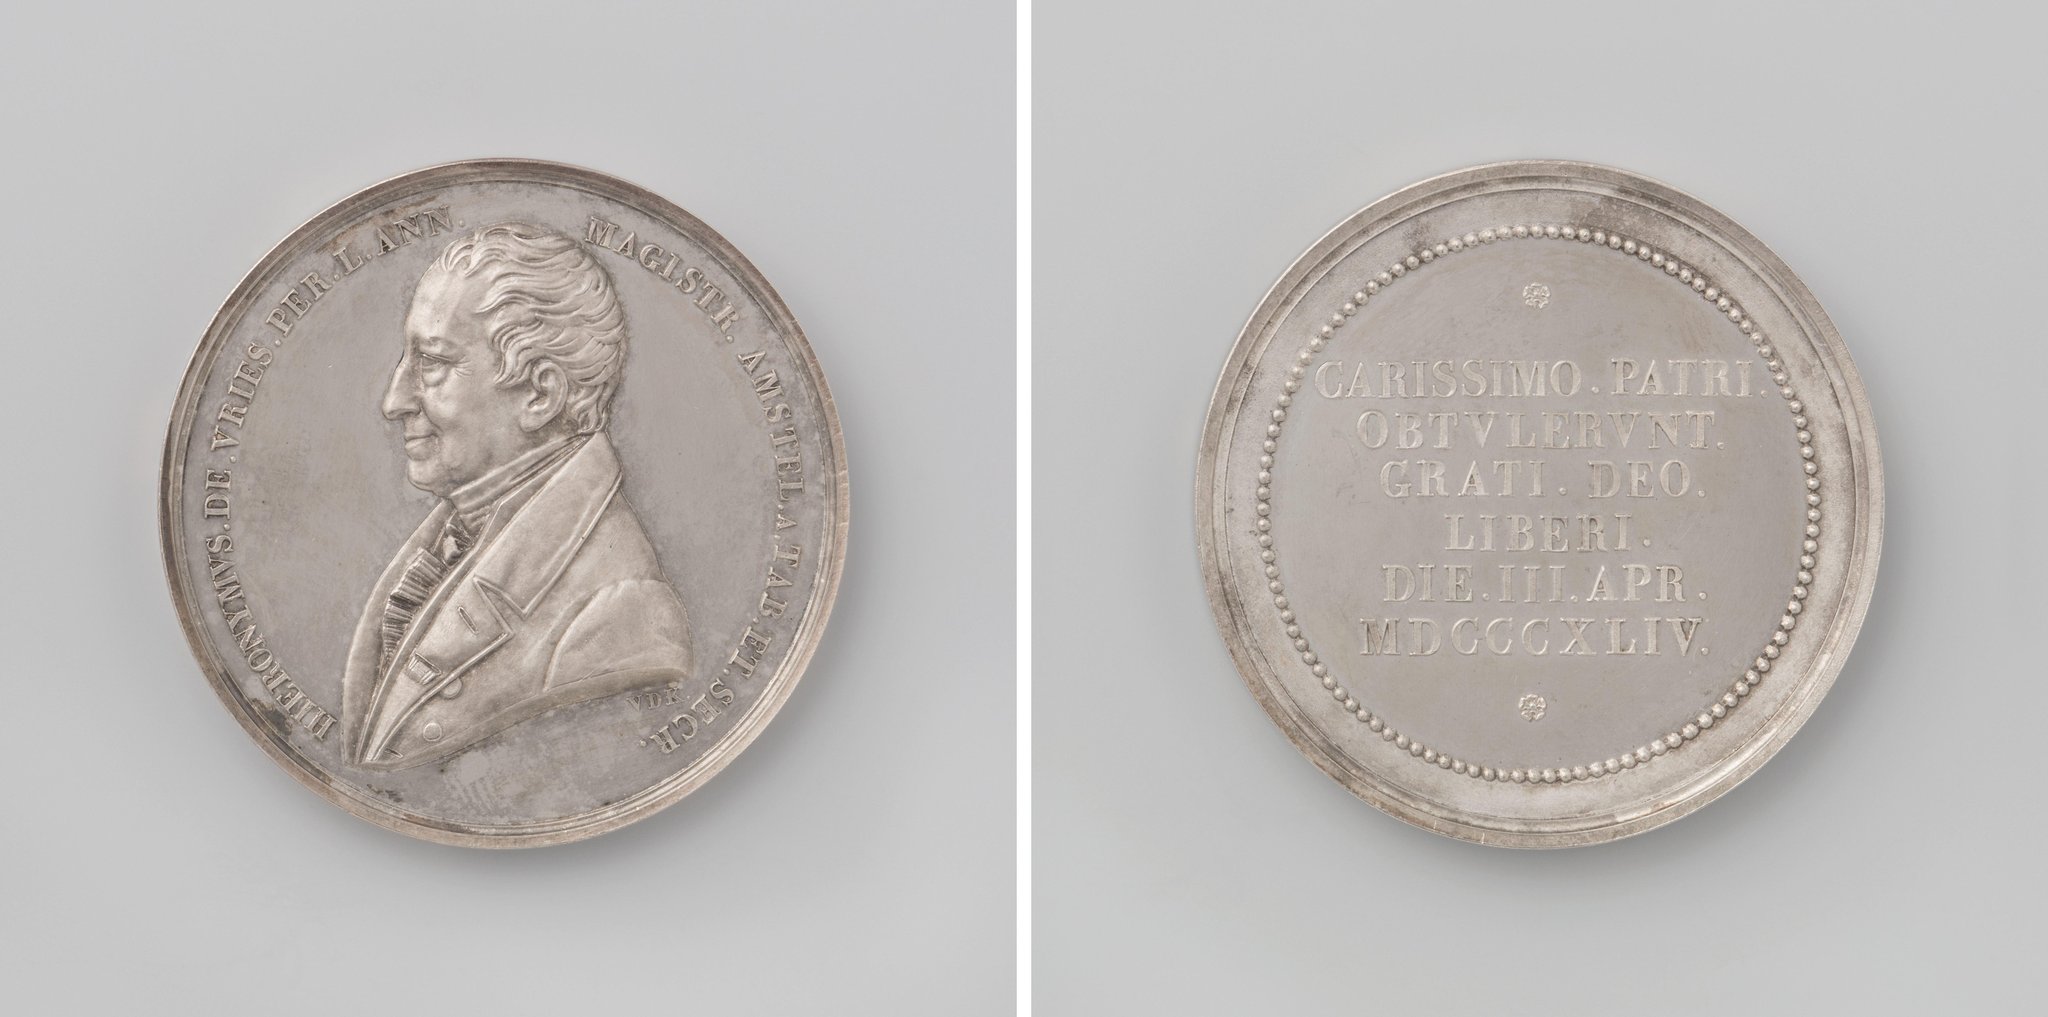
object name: honorary medal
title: Jeronimo de Vries (Hieronymus de Vries), vijftig jaar griffier en secretaris te Amsterdam, penning geslagen op last van zijn kinderen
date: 1844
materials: silver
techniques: striking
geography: utrecht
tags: jeronimo de vries, amsterdam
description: Zilveren penning. Voorzijde: borststuk man binnen omschrift. Keerzijde: opschrift binnen parelrand.